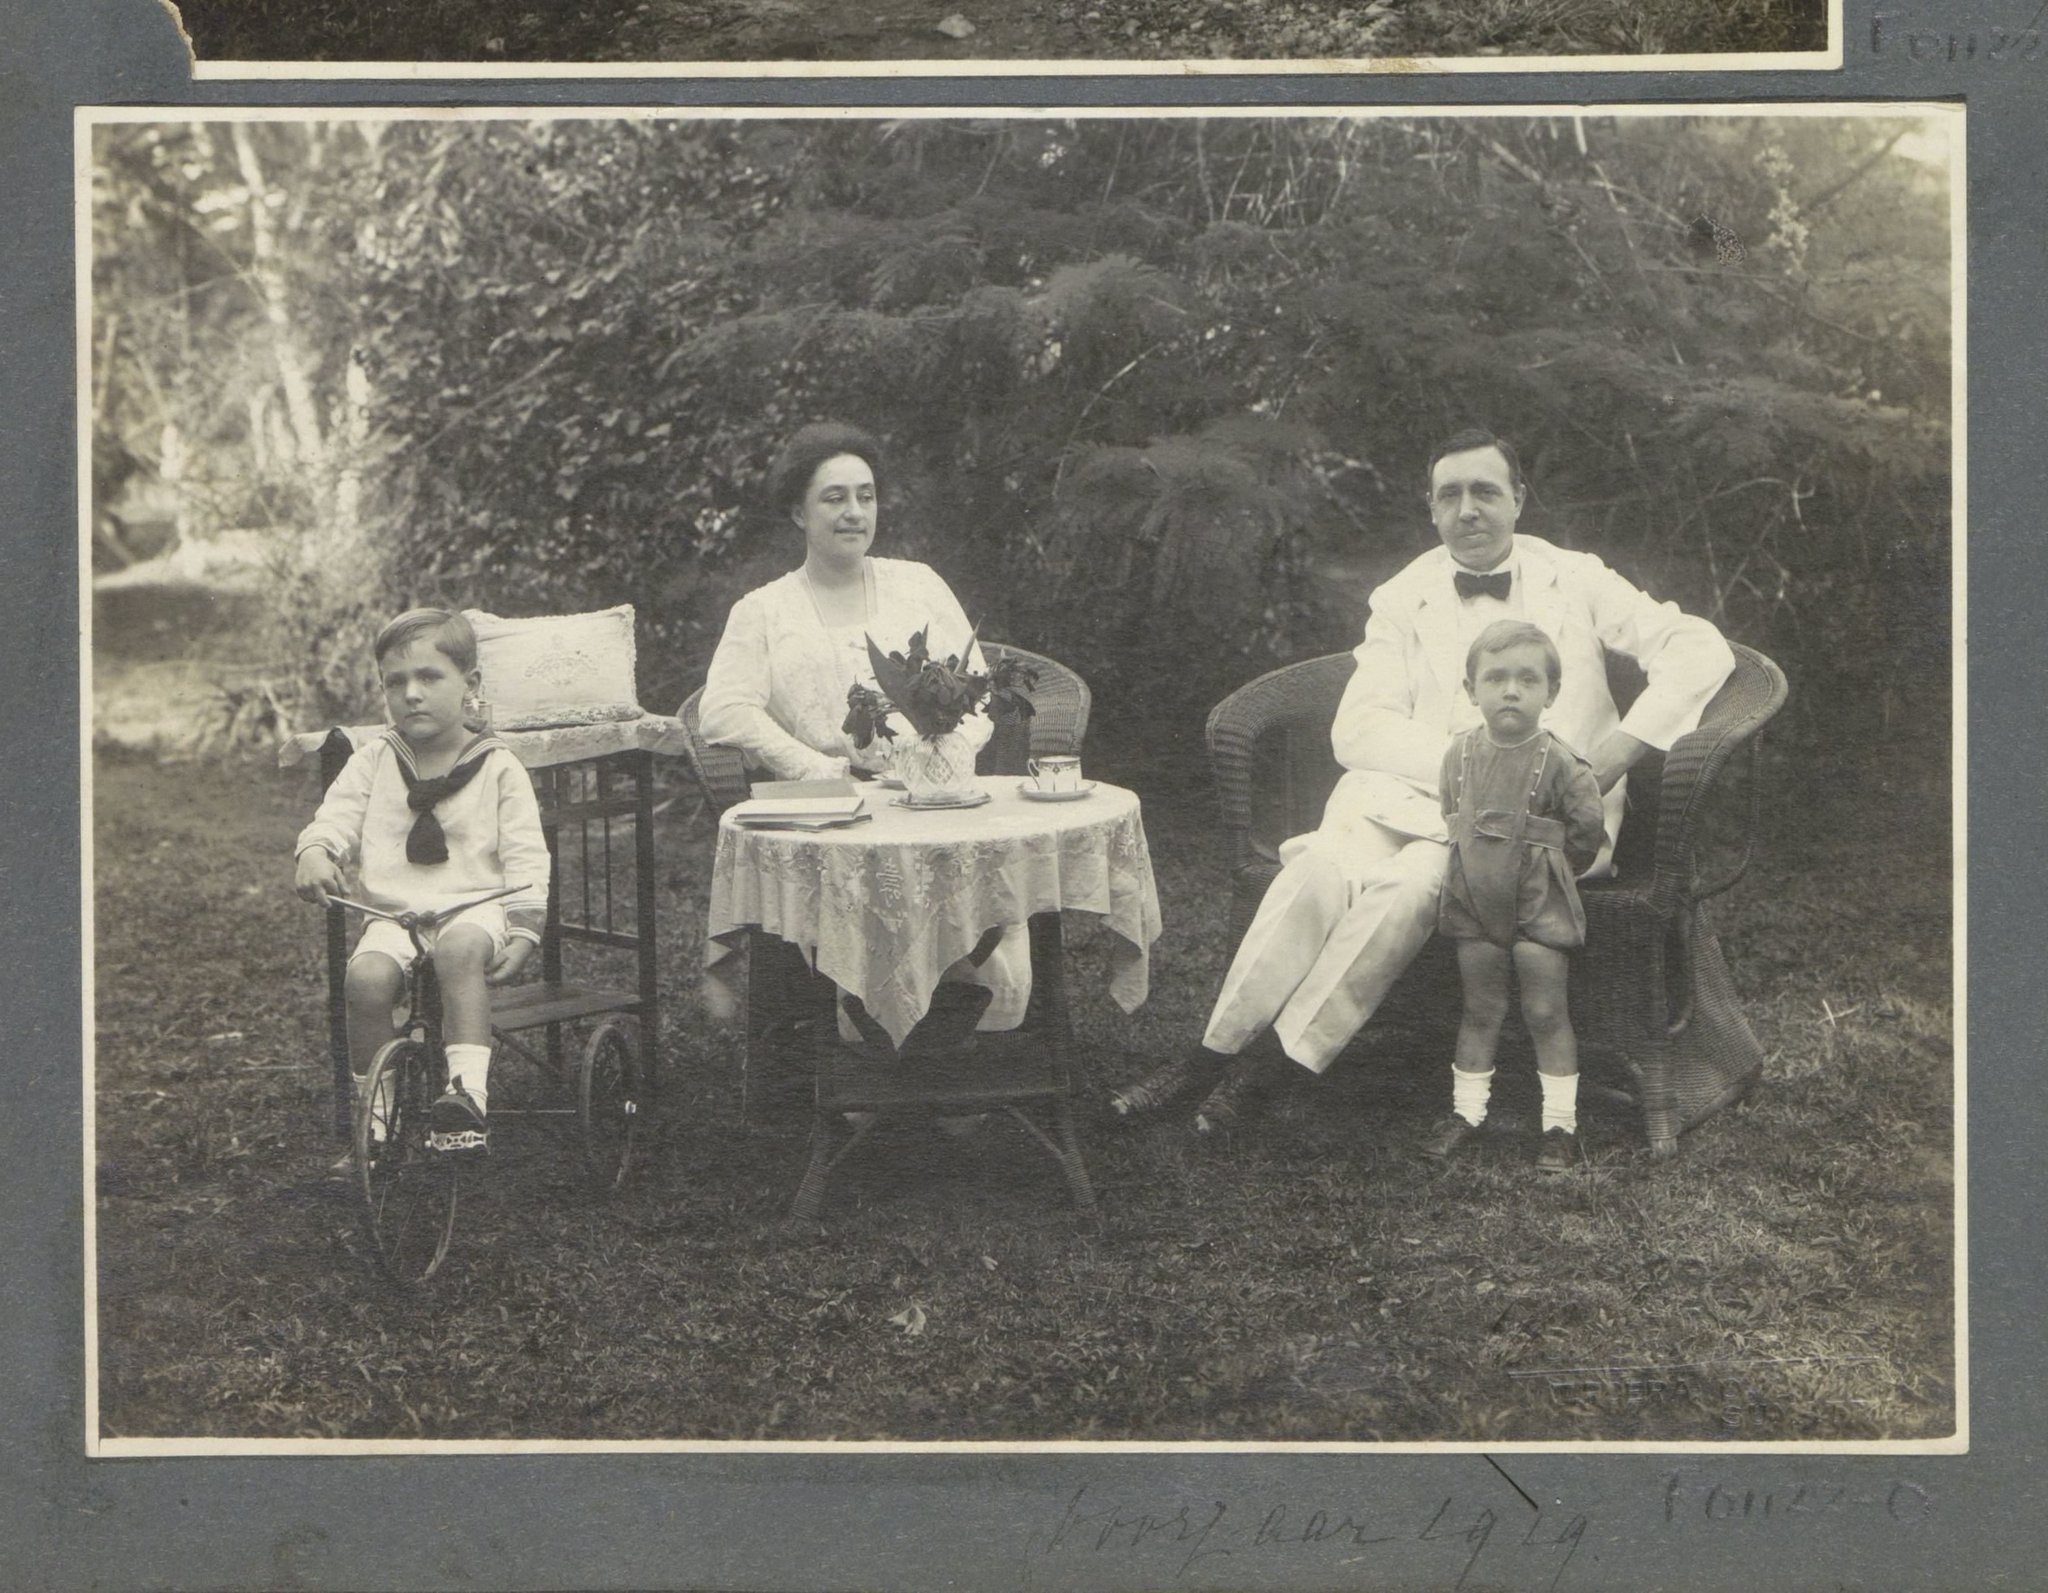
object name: photograph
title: Eiso en Gerda Bergsma met hun kinderen Georges en Hans aan tafel in een tuin op Sumatra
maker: mikado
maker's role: fotograaf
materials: photographic support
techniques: gelatin silver print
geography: sumatra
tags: tricycle, family group, especially parents with their child(ren), family life, sumatra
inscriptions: name: ‘Mikado T. Poera O.K.V. Sumatra’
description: Onderdeel van fotoalbum met opnames van de familie Bergsma in Tandjong Poera en Rantan Pandjang (Sumatra).